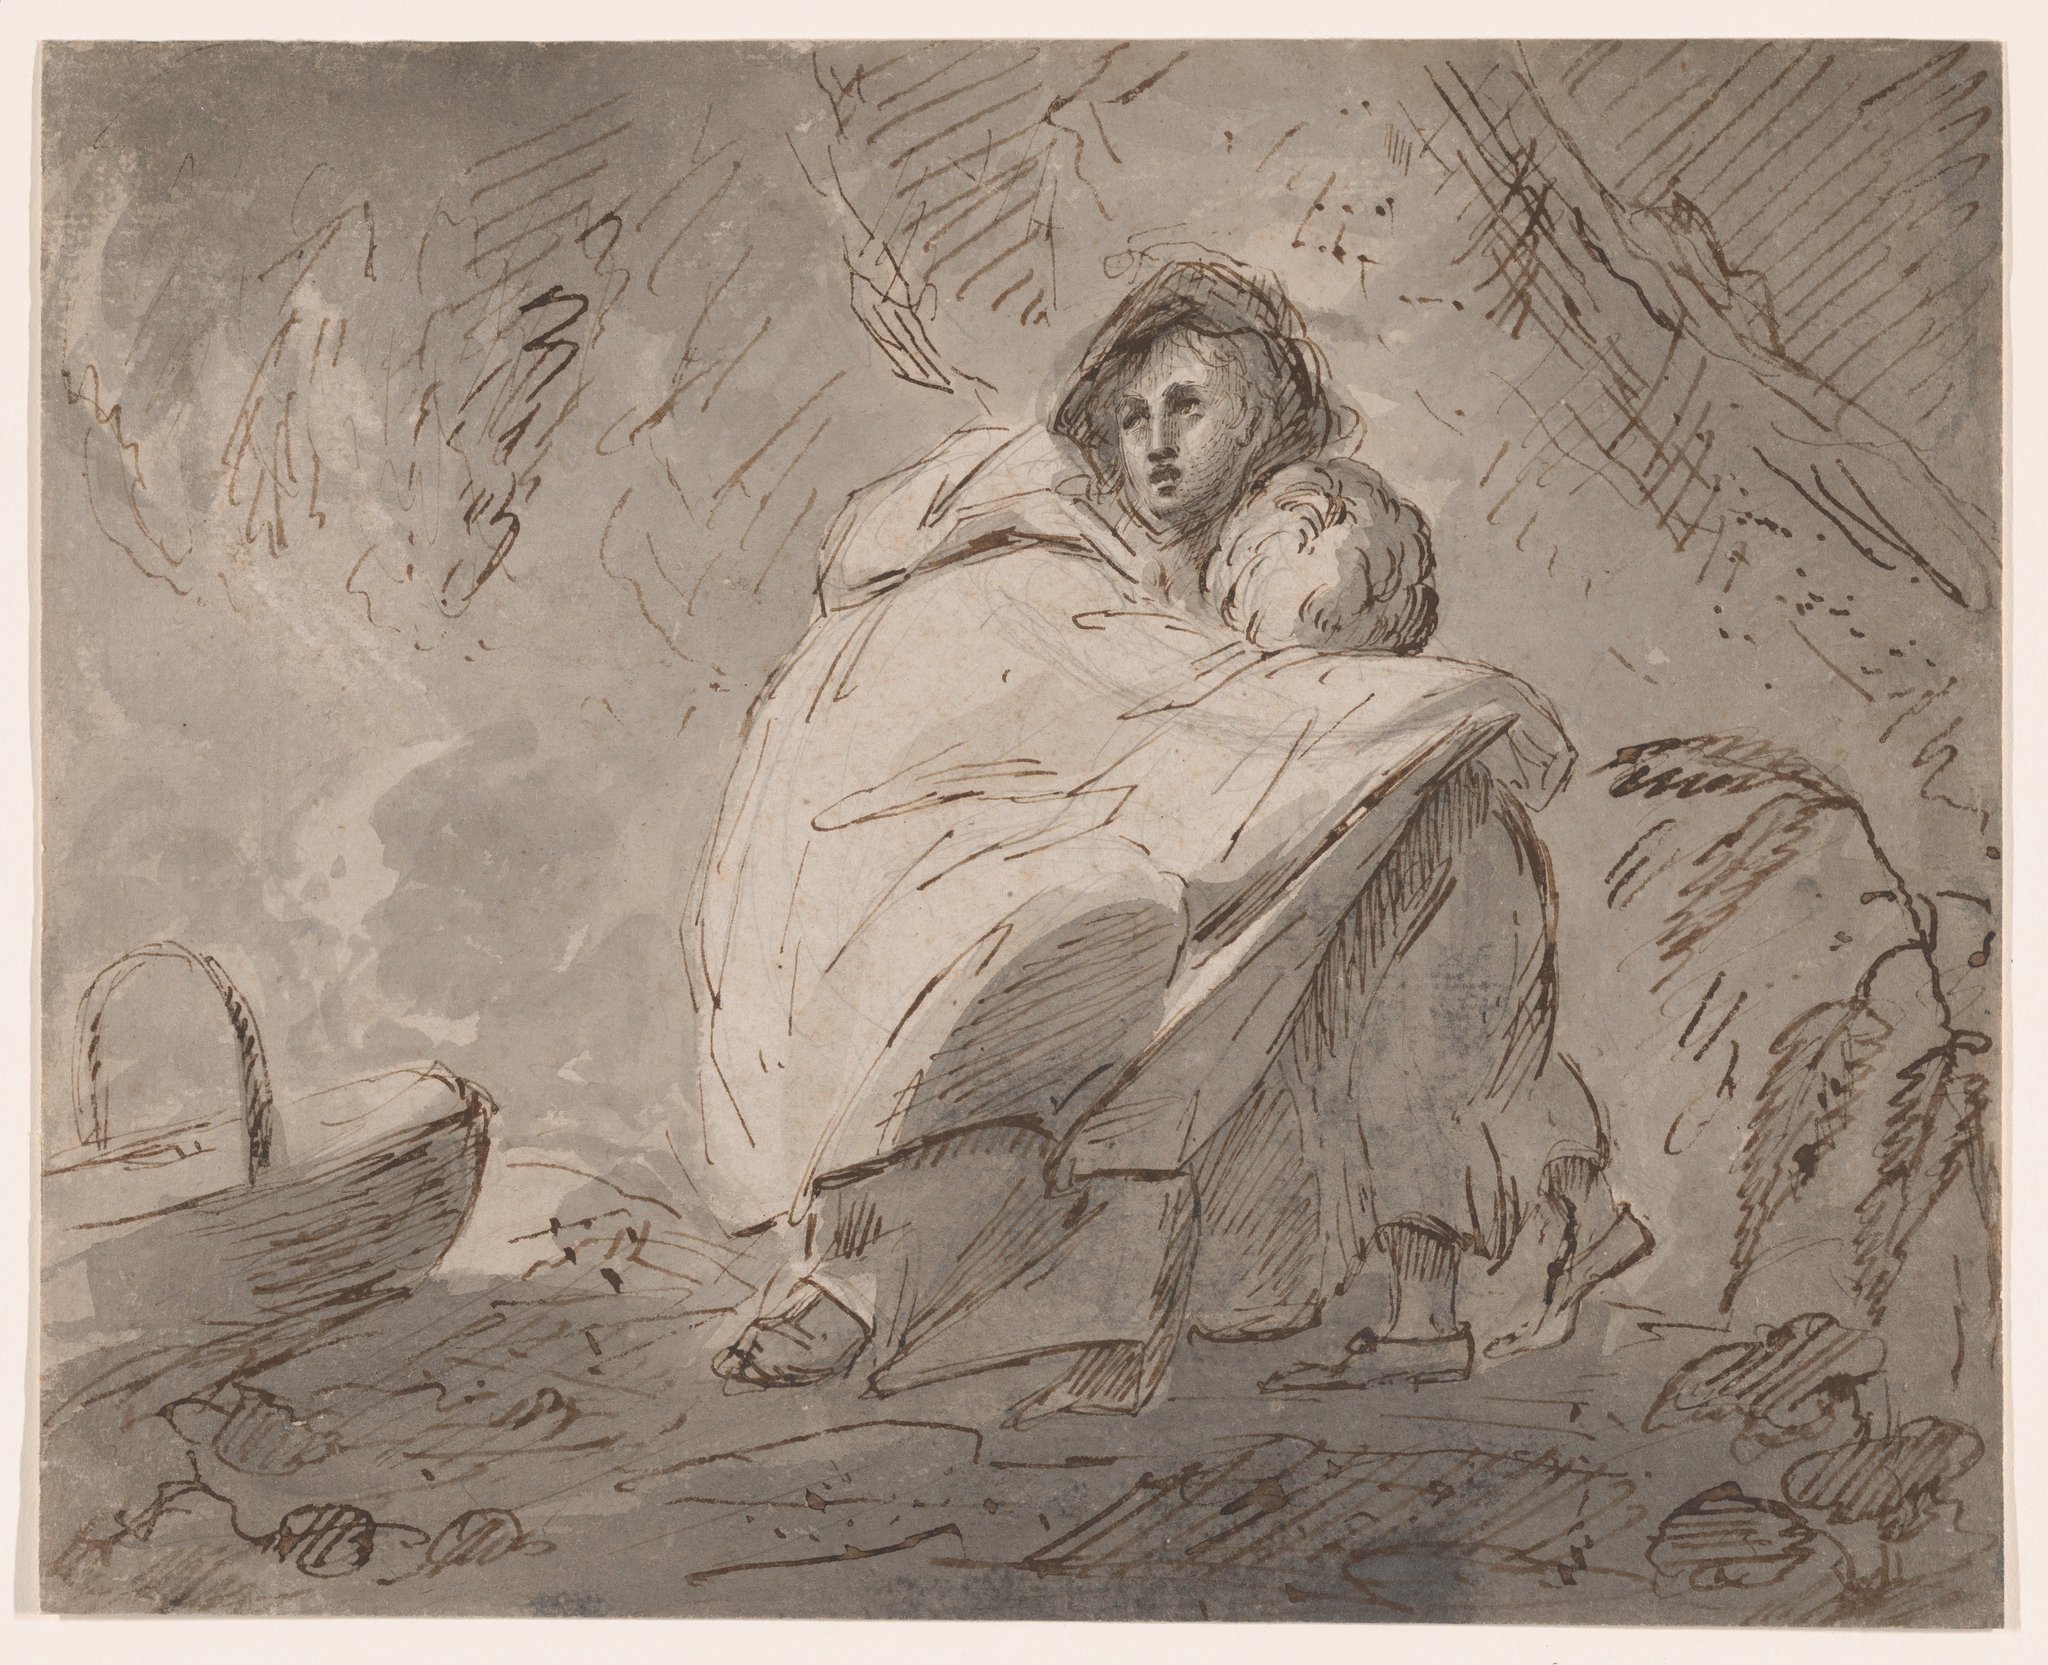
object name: drawing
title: Woman sheltering a child in a landscape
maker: william hamilton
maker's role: artist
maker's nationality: british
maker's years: 1751-1801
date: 1770-1780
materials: graphite, ink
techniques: brush, pen, wash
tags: children,women